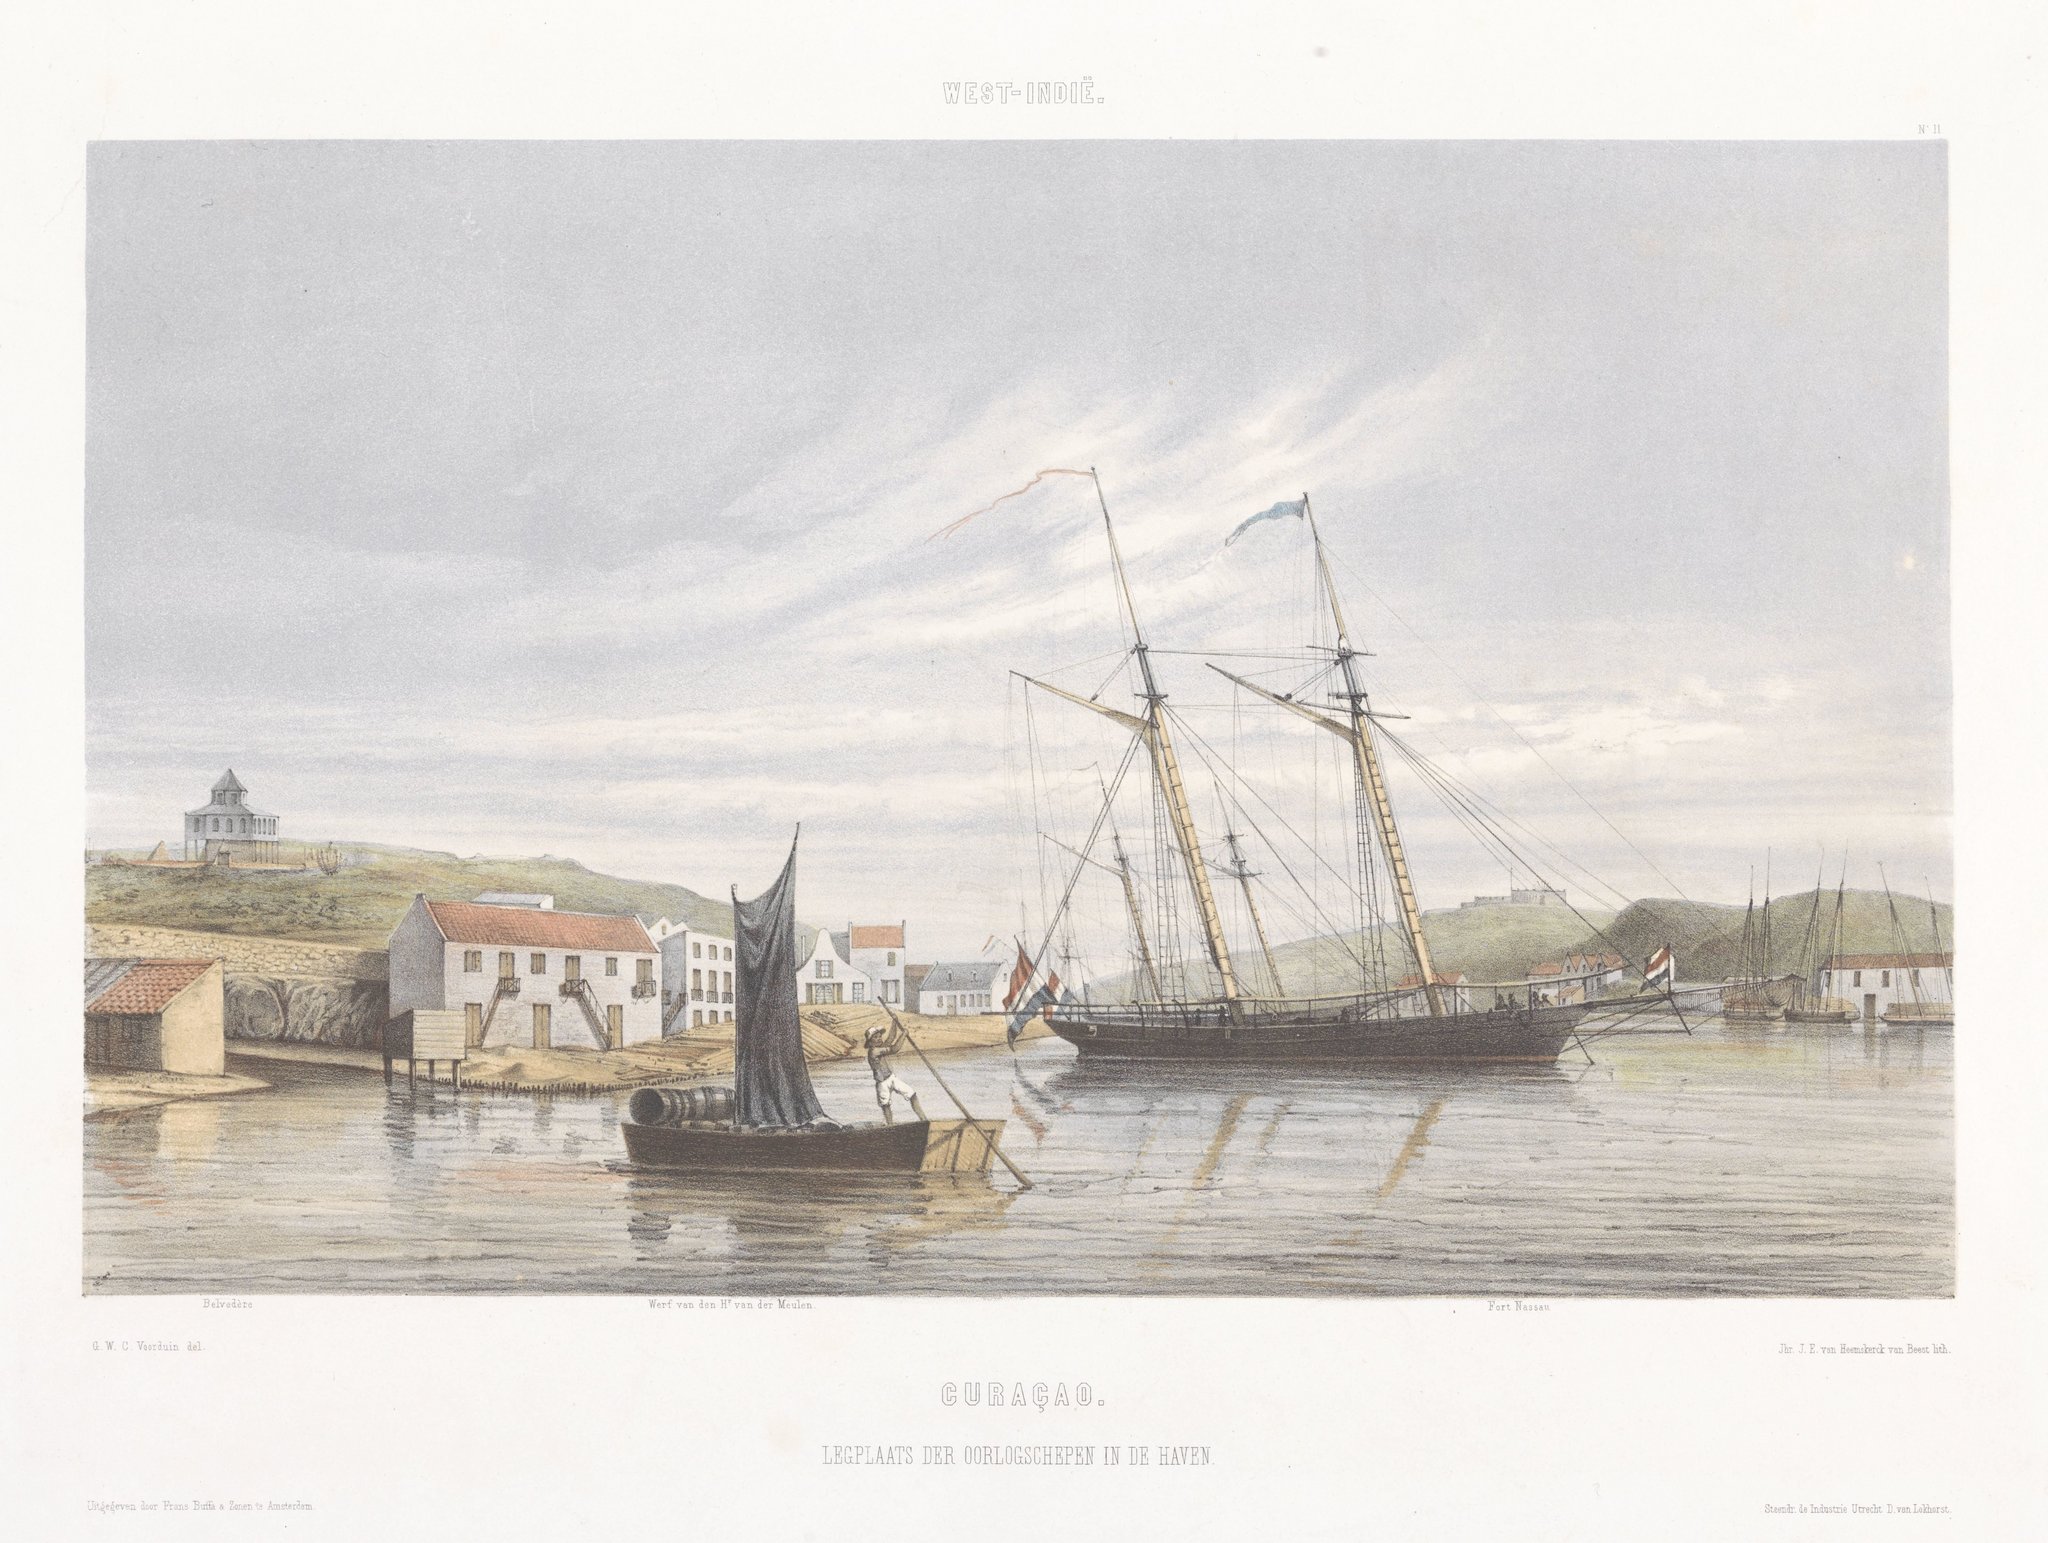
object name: print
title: Legplaats voor oorlogsschepen in de haven van Curaçao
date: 1860-1862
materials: paper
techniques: lithograph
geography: amsterdam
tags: harbour, ships (in general)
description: Op de rivier en aan de kade liggen verschillende boten. In het midden een roeiboot en een zeilschip. Links op een heuvel ligt het Belvedère. Onder de afbeelding staan plaatsen aangegeven zoals Werf van den H. van der Meulen en Fort Nassau.